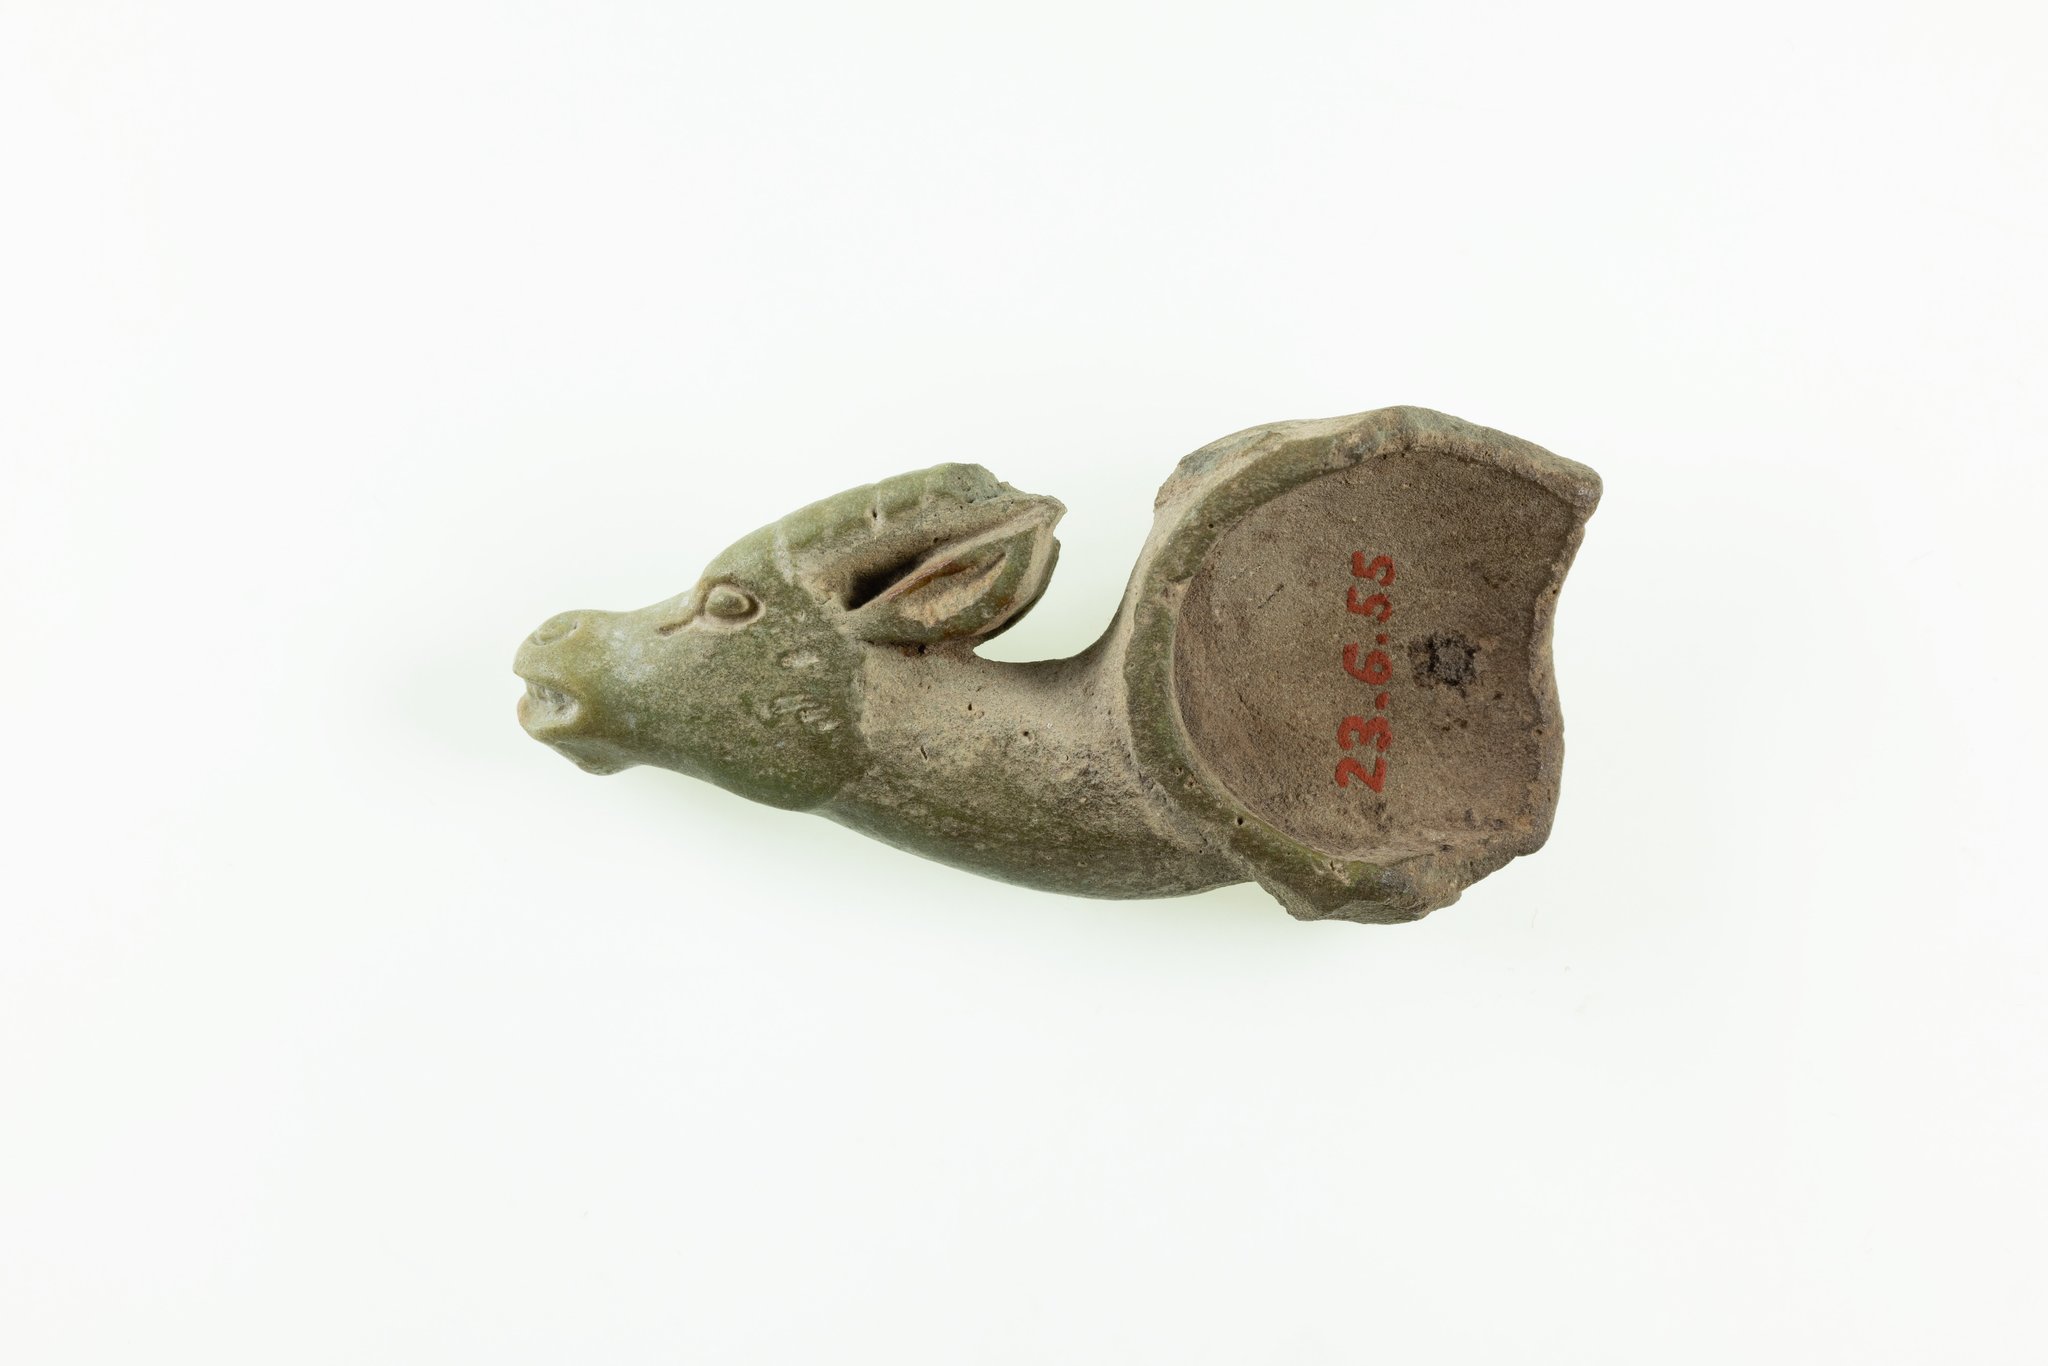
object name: dish fragment, gazelle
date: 1295-1070 BCE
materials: faience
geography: egypt